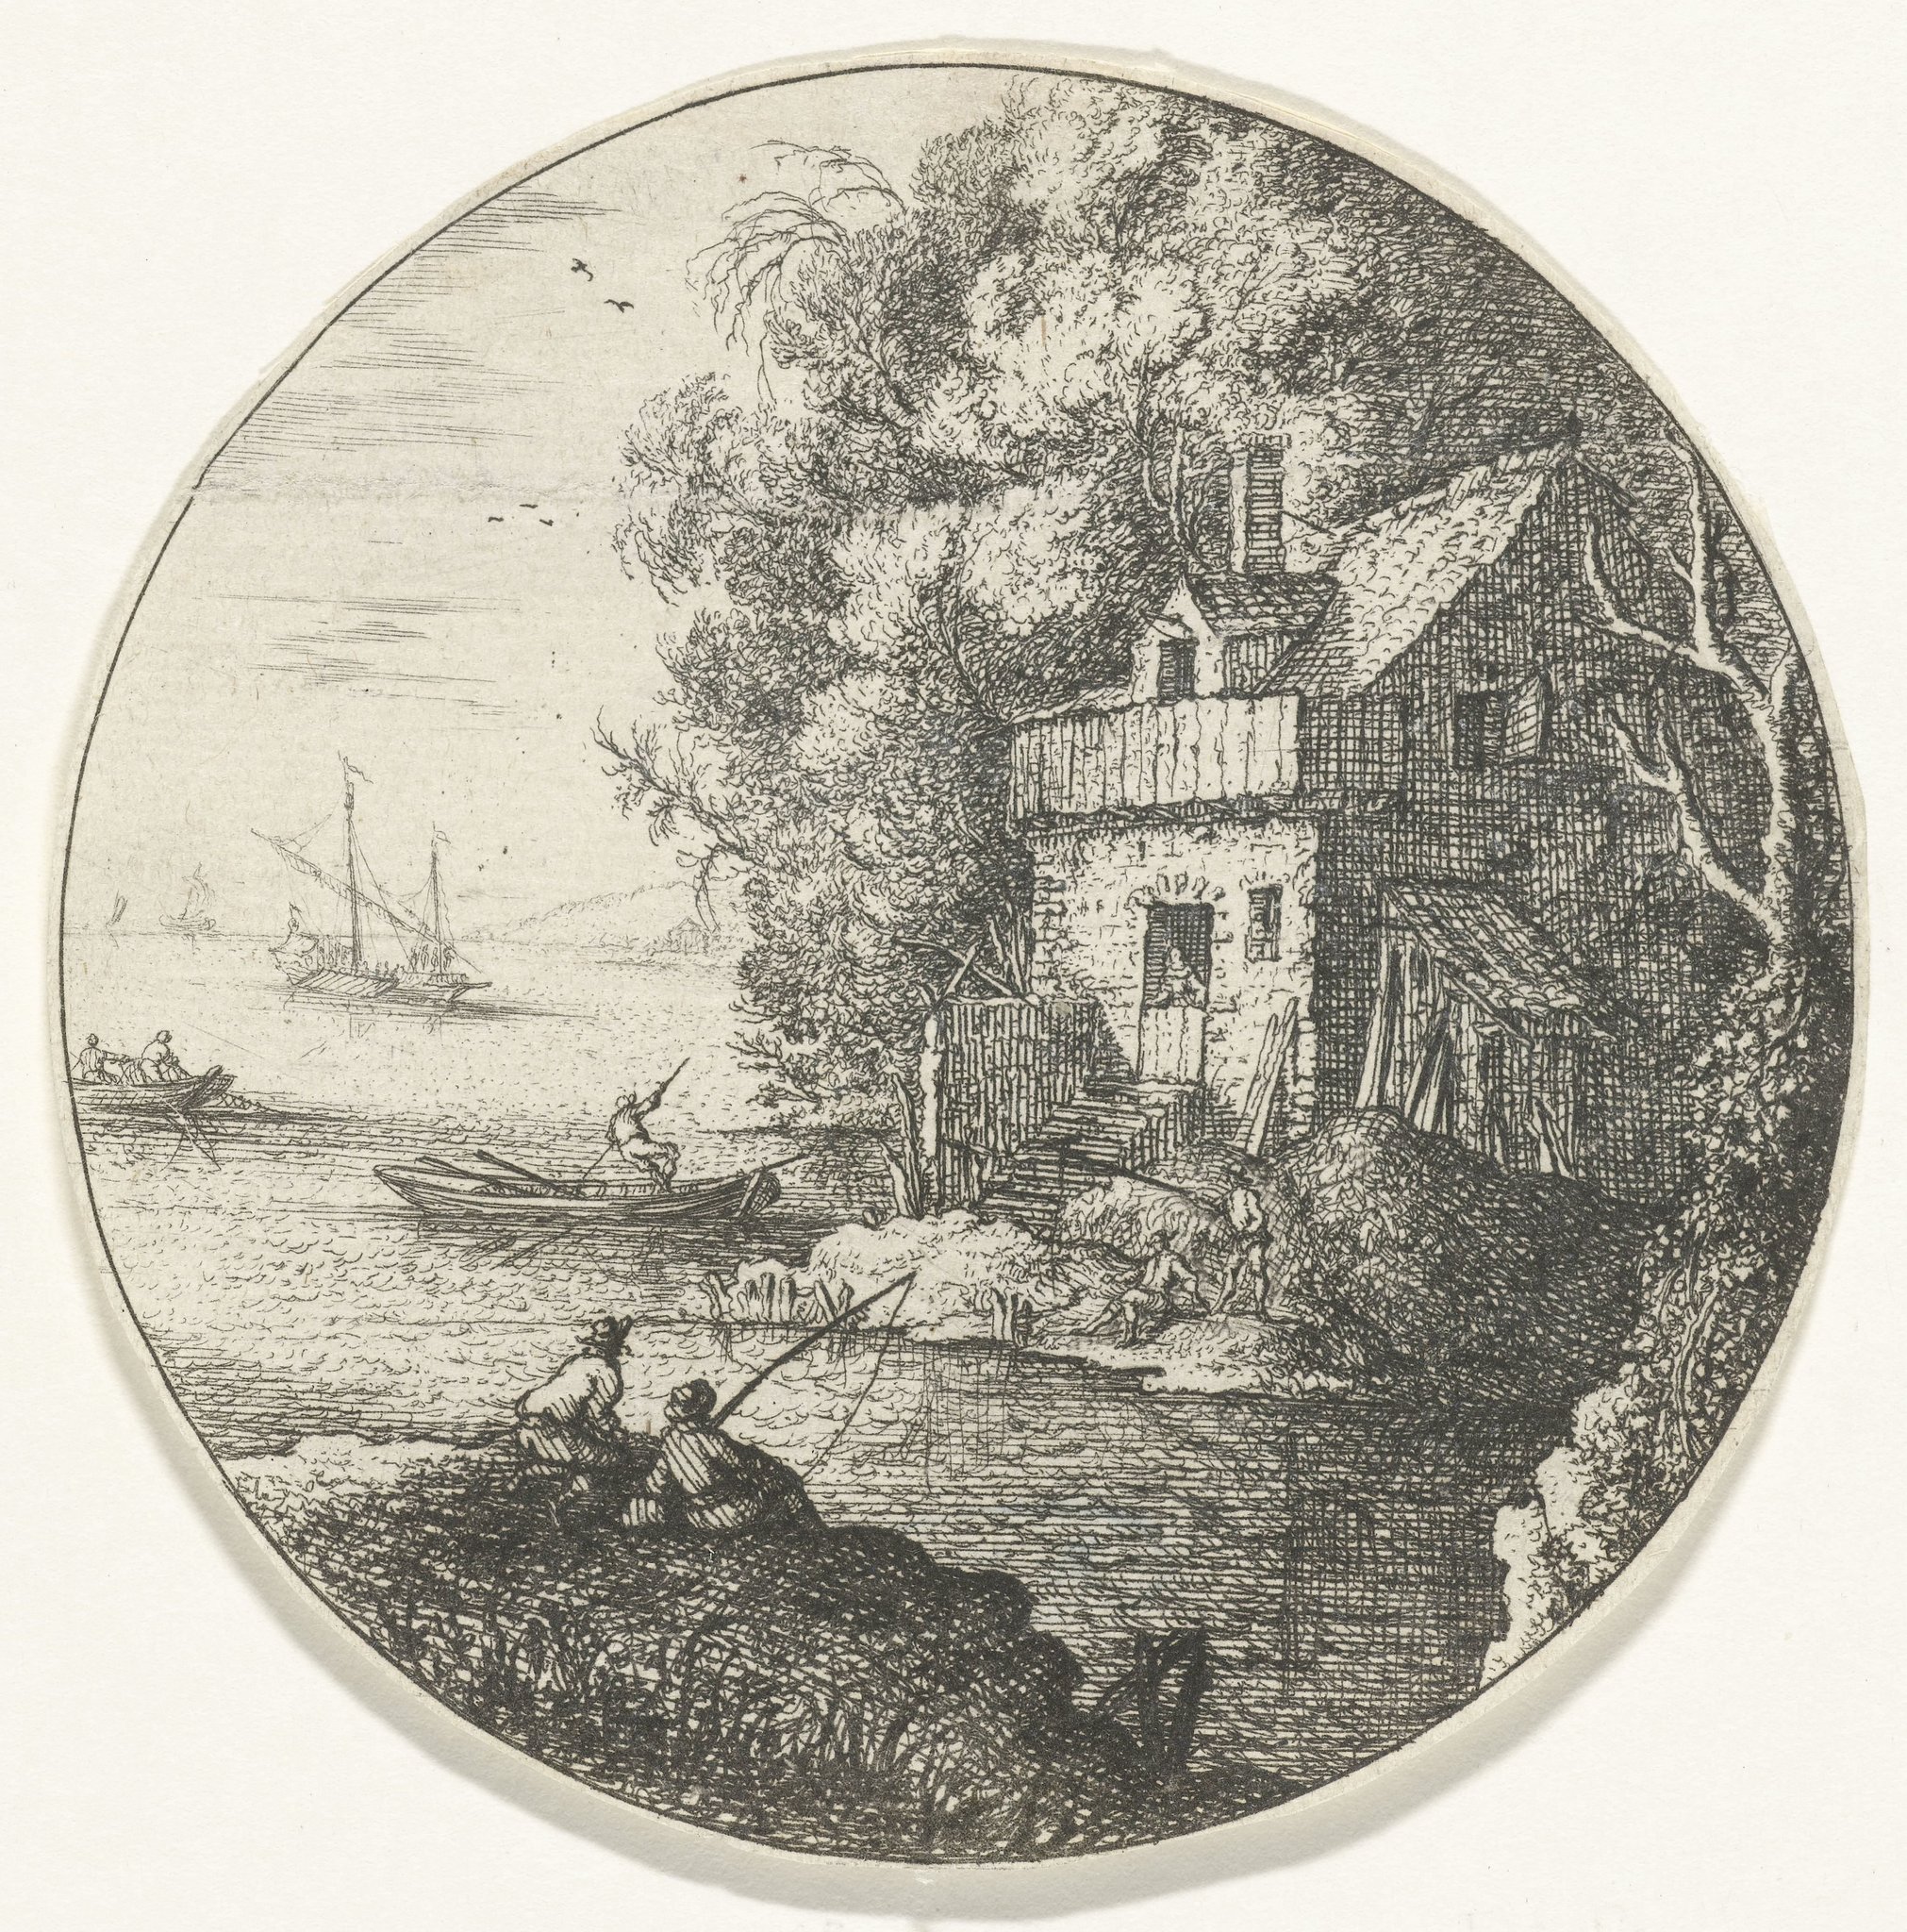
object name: print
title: Landschap met twee vissers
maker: albert flamen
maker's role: draughtsman, print maker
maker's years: 1620-1691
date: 1648-1683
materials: paper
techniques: etching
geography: paris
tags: fisherman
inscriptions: collector's mark: Lugt 2228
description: Cirkelvormig gezicht op een huis aan de waterkant. Op de voorgrond twee vissers op de oever van de rivier.